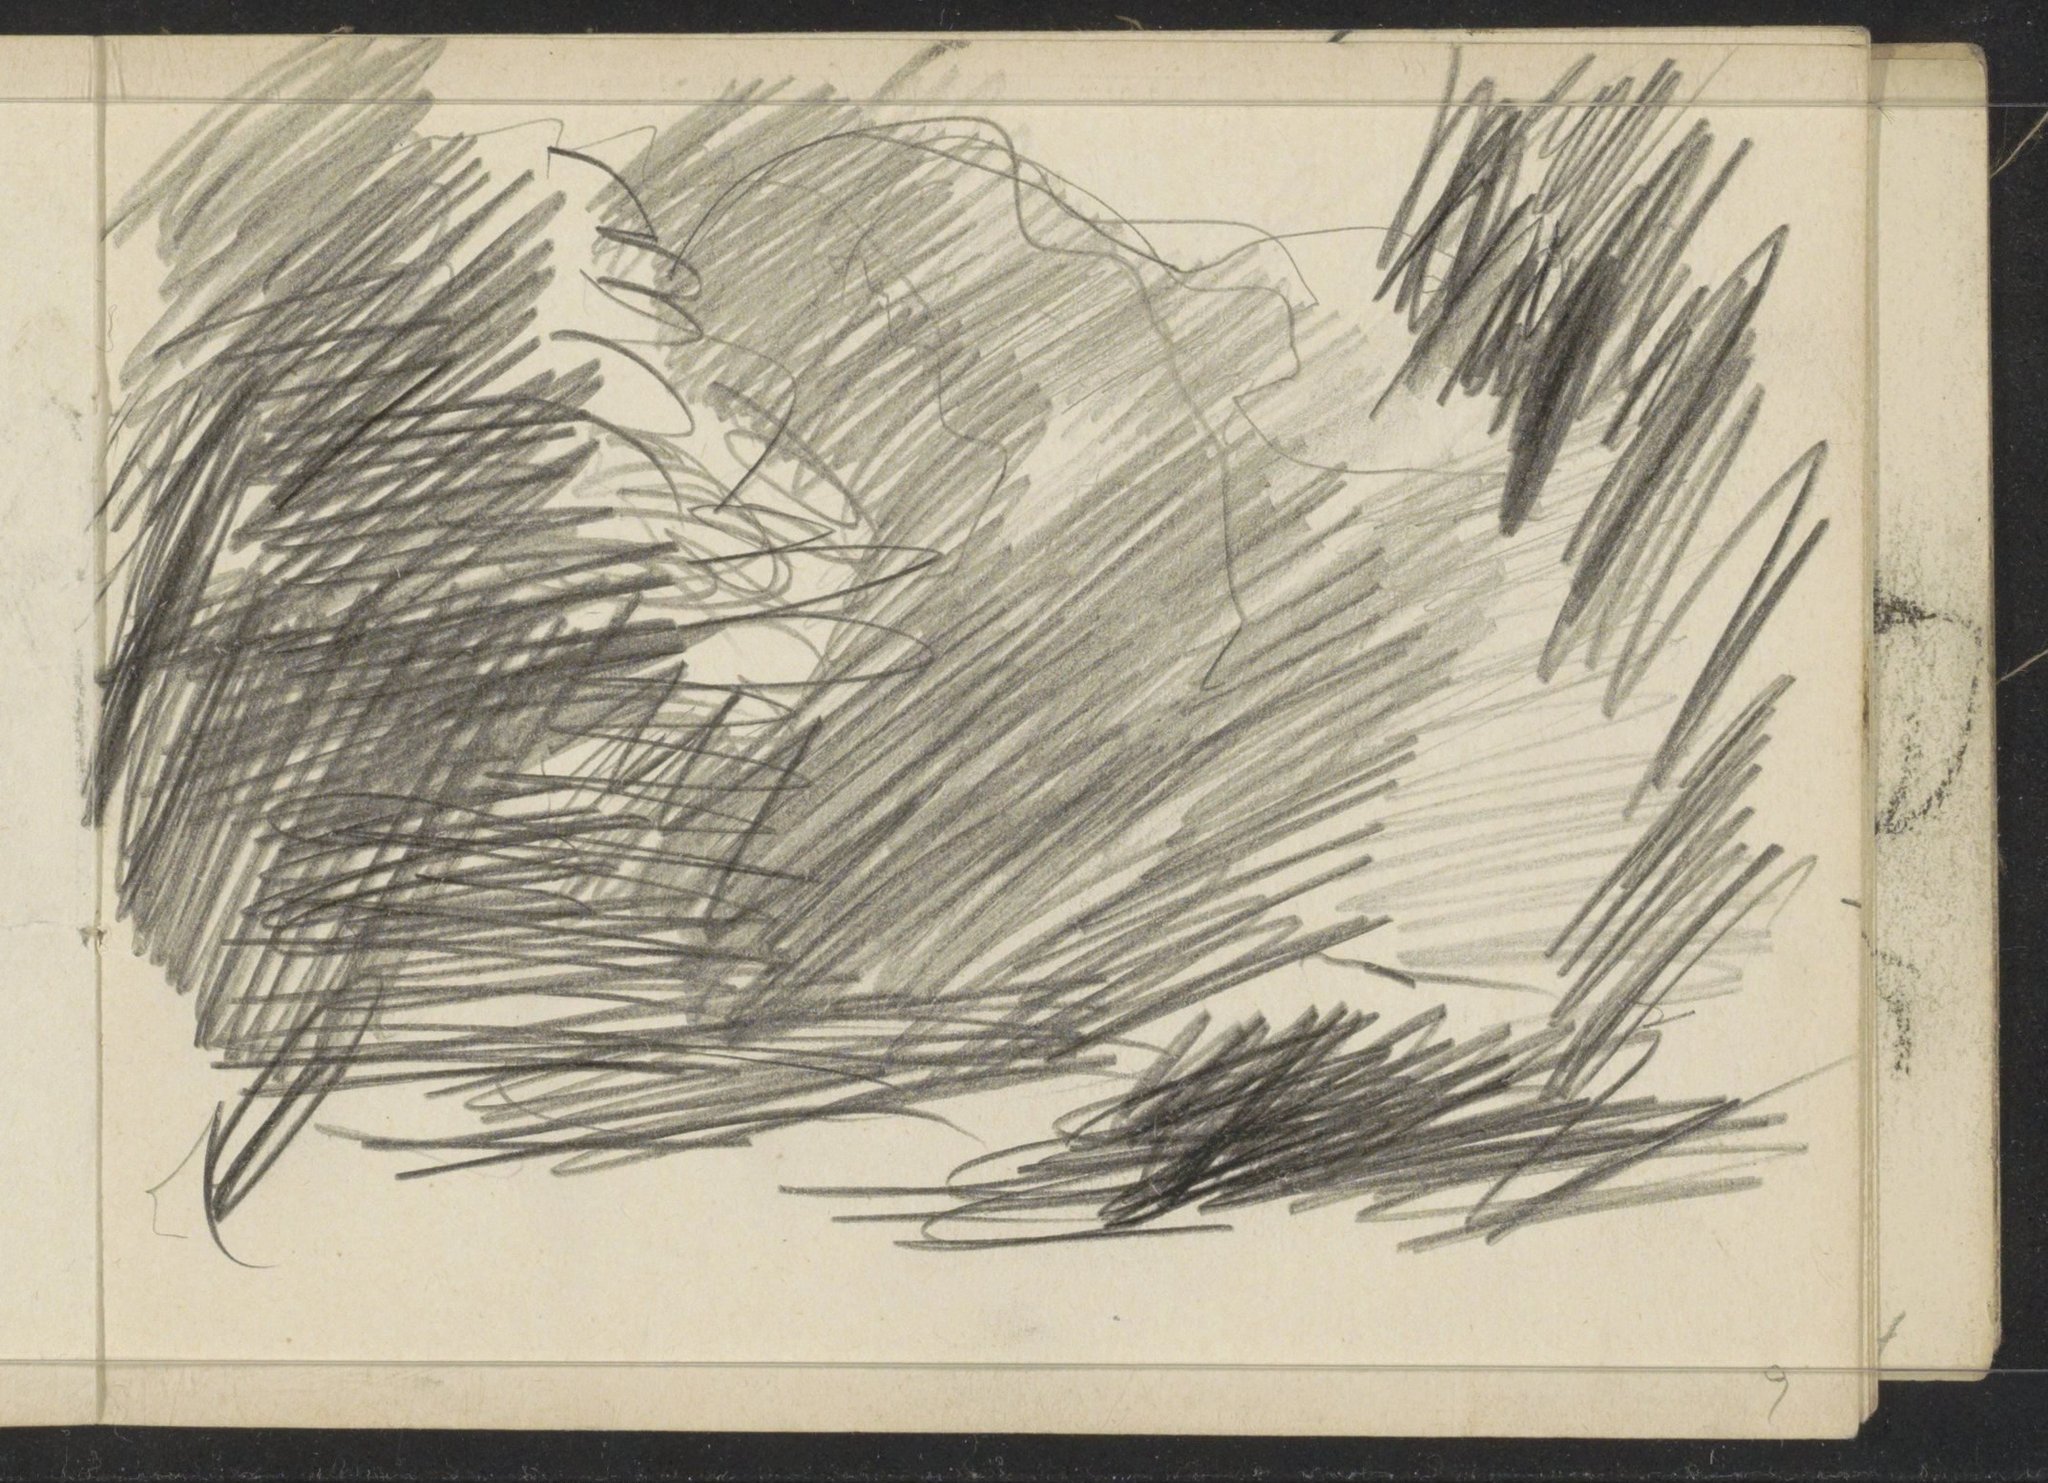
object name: sketchbook leaf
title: Studie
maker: isaac israels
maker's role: draughtsman, painter, print maker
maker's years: 1865-1934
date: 1923-1934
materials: paper, pencil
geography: the hague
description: Blad 9 recto uit schetsboek LVIII met 14 bladen.